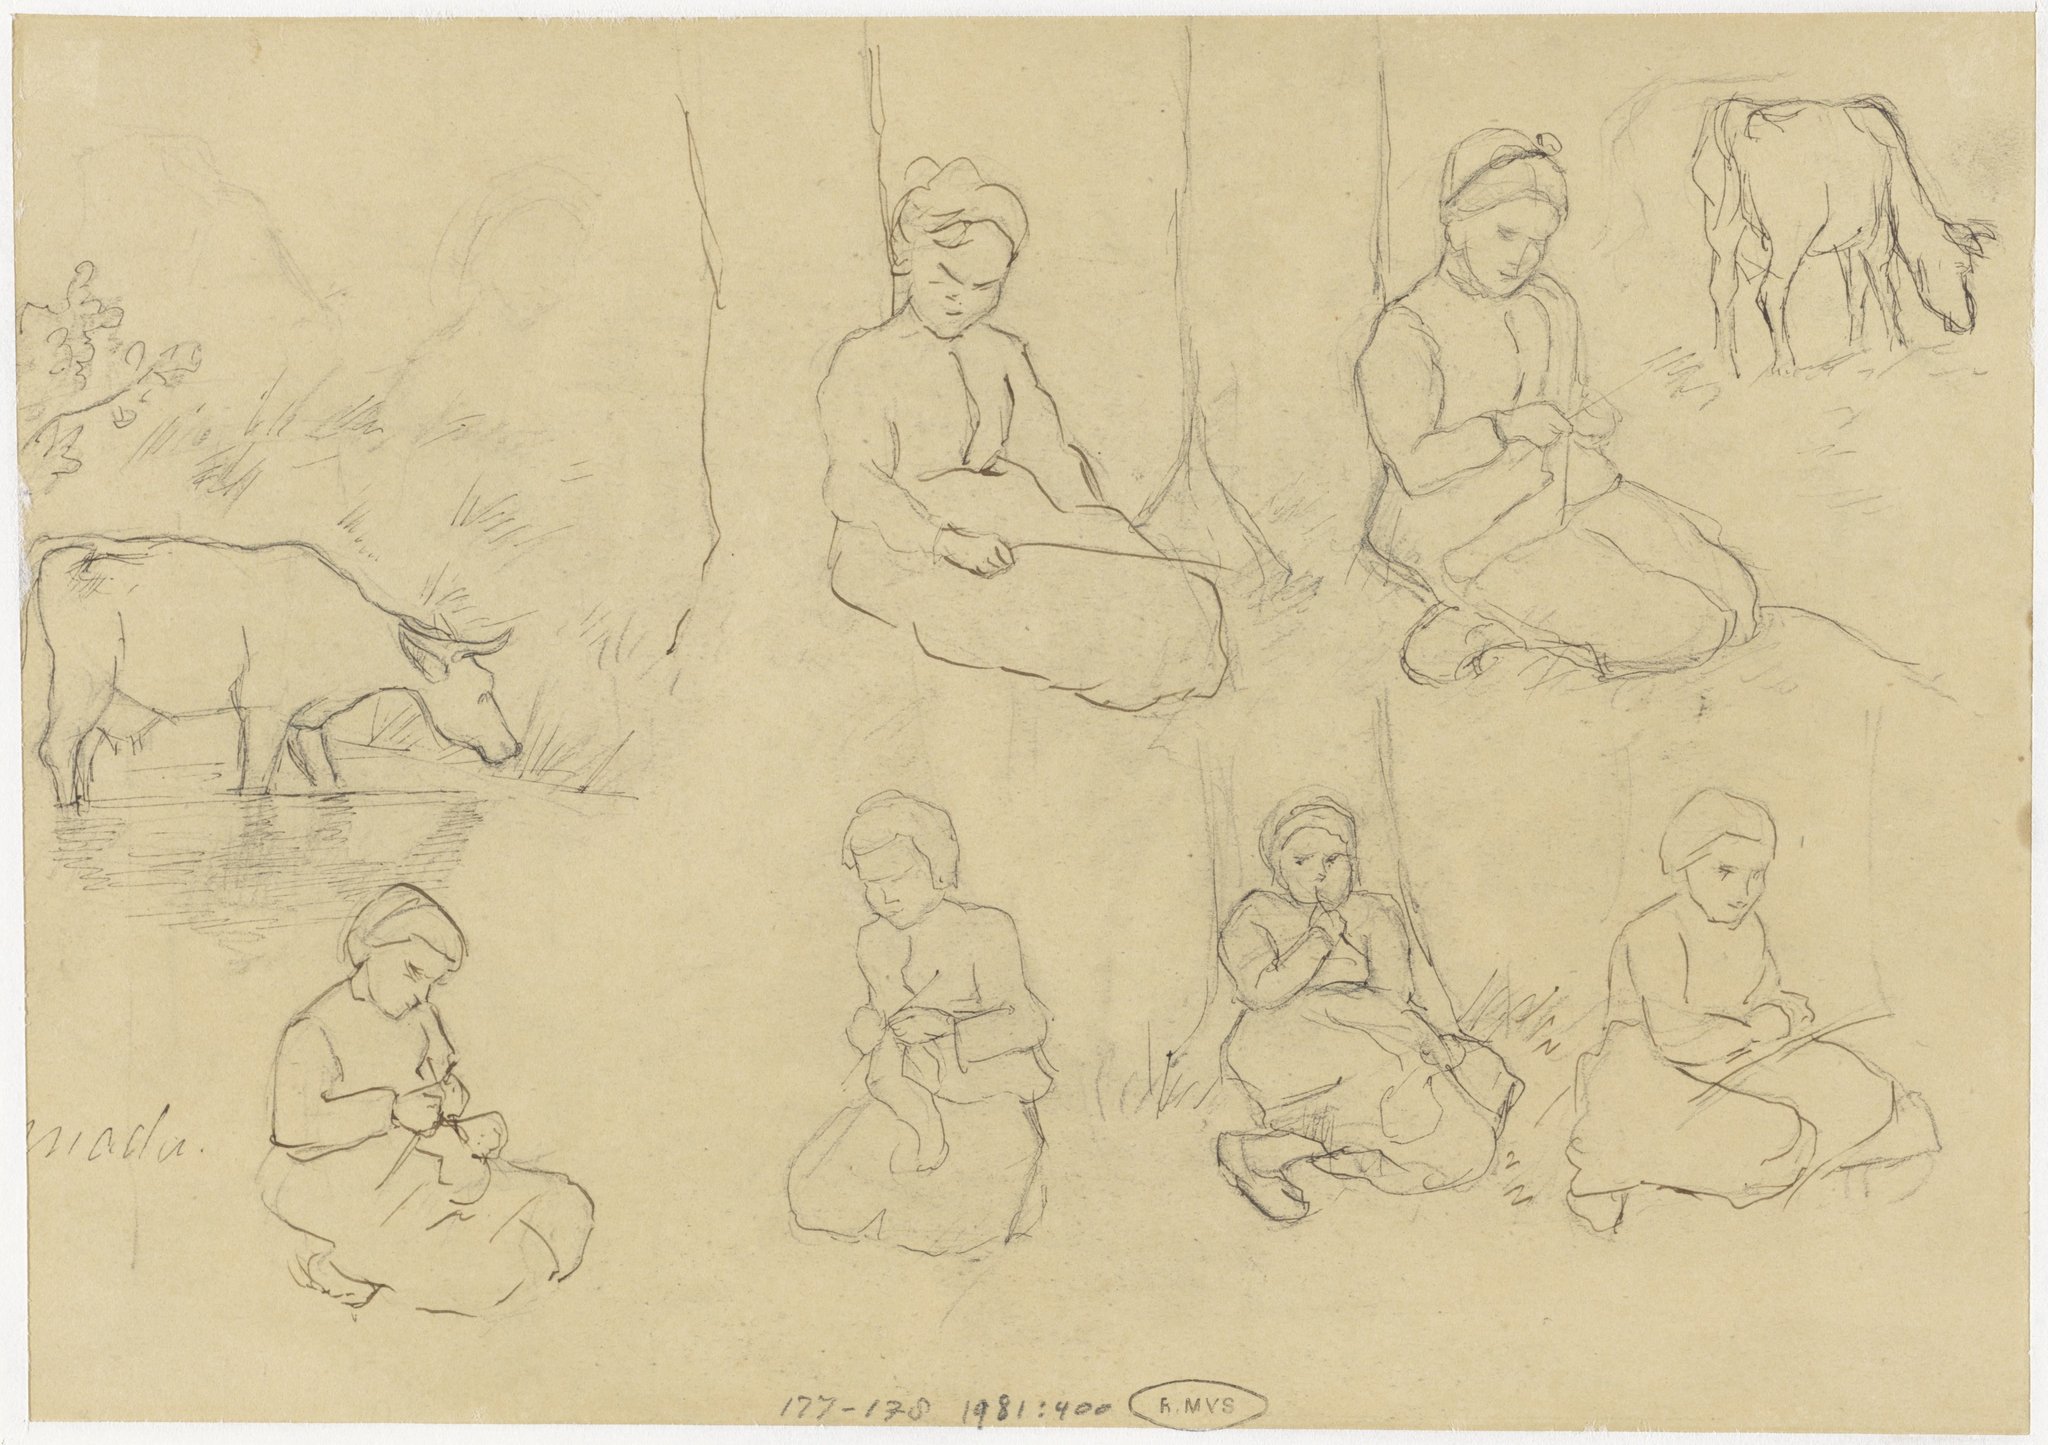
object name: drawing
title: Studies van een handwerkende vrouw onder een boom en koeien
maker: jozef israëls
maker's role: draughtsman, painter, print maker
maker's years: 1824-1911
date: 1834-1911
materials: ink, paper, pencil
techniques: pen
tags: cow, (other forms of) needlework, e.g.: crocheting, knitting, embroidering